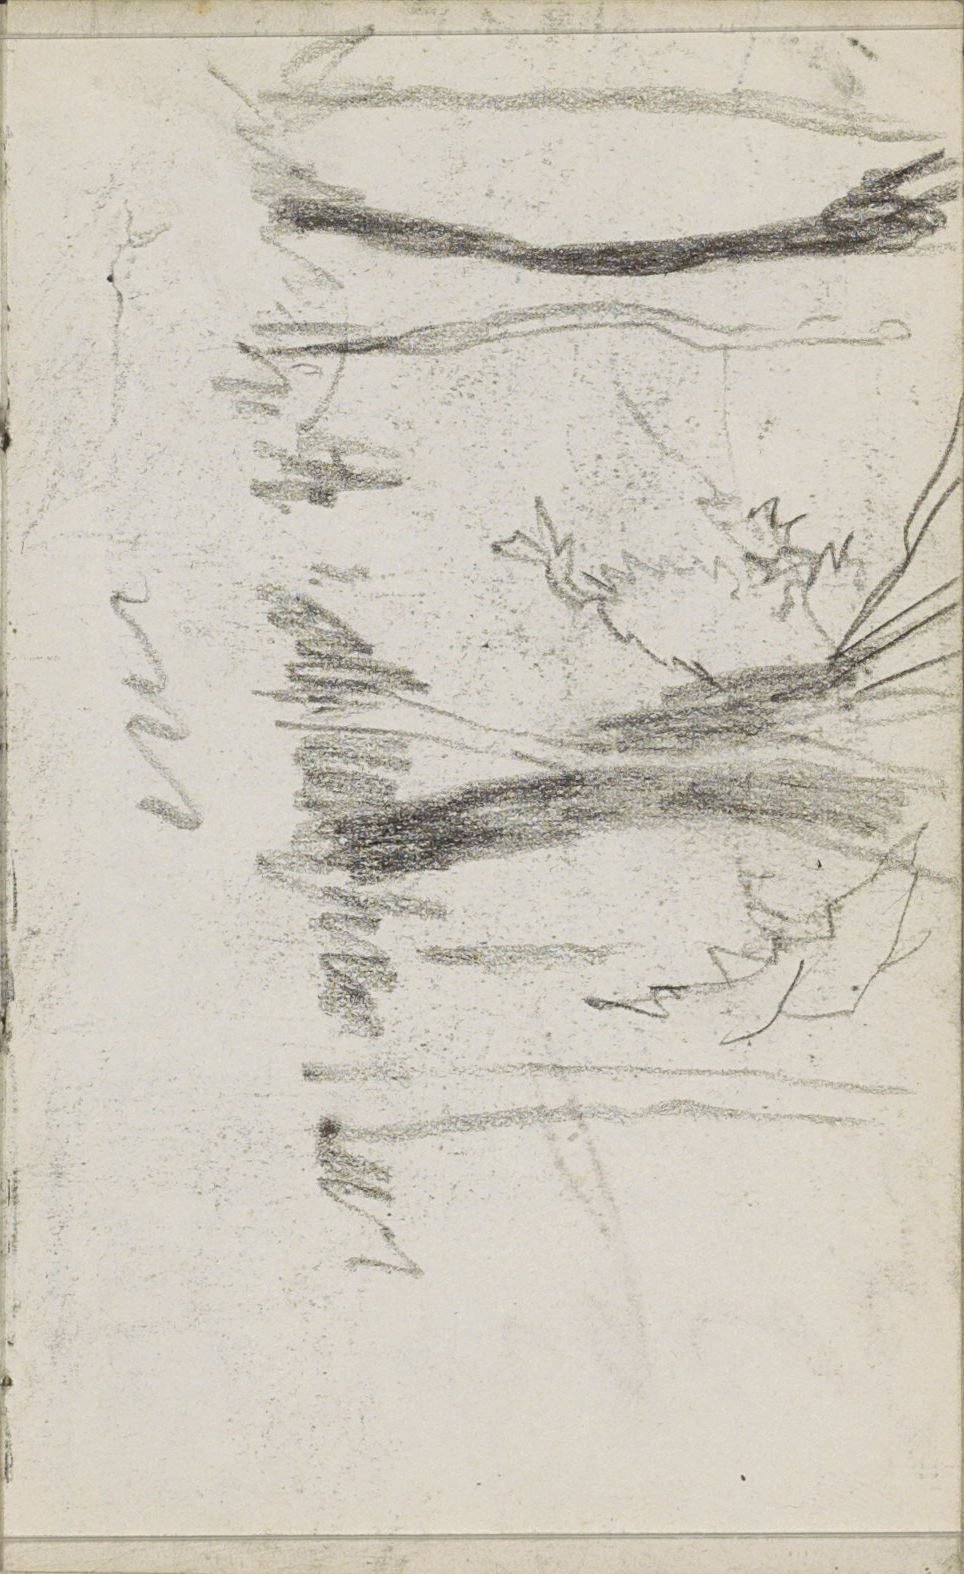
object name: sketchbook leaf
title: Boomstammen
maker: anton mauve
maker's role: draughtsman, painter, print maker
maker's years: 1838-1888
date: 1848-1888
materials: chalk, paper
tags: trees (+ stem, trunk), forest, wood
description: Blad 35 recto uit een schetsboek met 53 bladen.